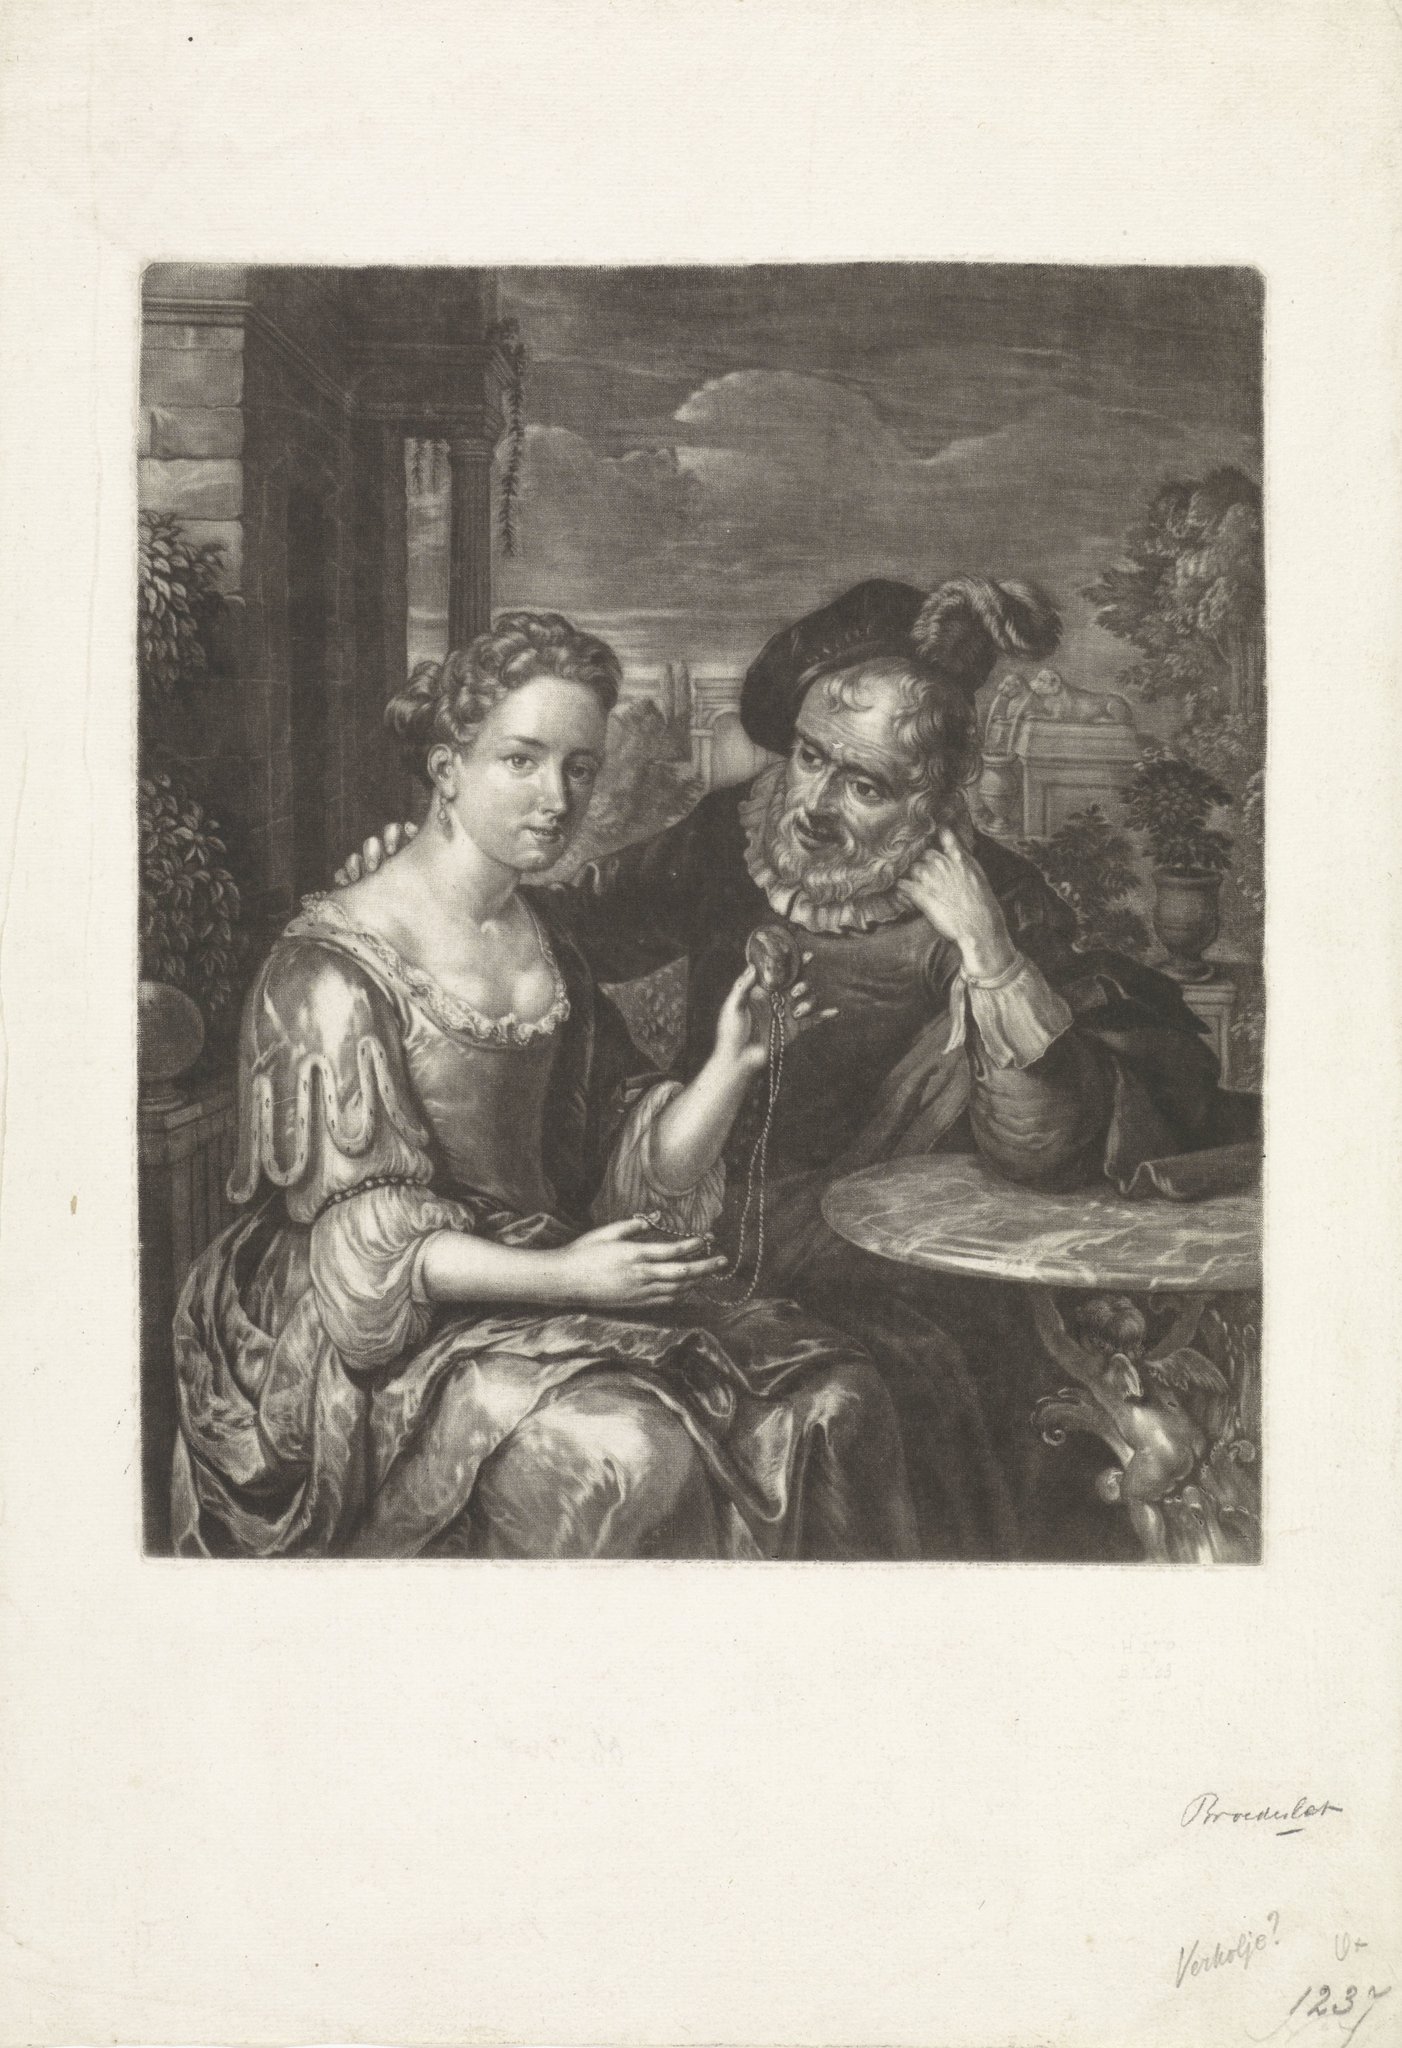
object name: print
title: Jonge vrouw en oude man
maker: jan broedelet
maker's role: print maker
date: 1670-1700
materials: paper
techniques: mezzotint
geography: netherlands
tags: garden, married couple of unequal age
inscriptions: collector's mark: Lugt 2228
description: In een tuin zitten een oude man en een jonge vrouw. Zij heeft een medaillon in de hand en hij heeft zijn hand op haar schouder gelegd.